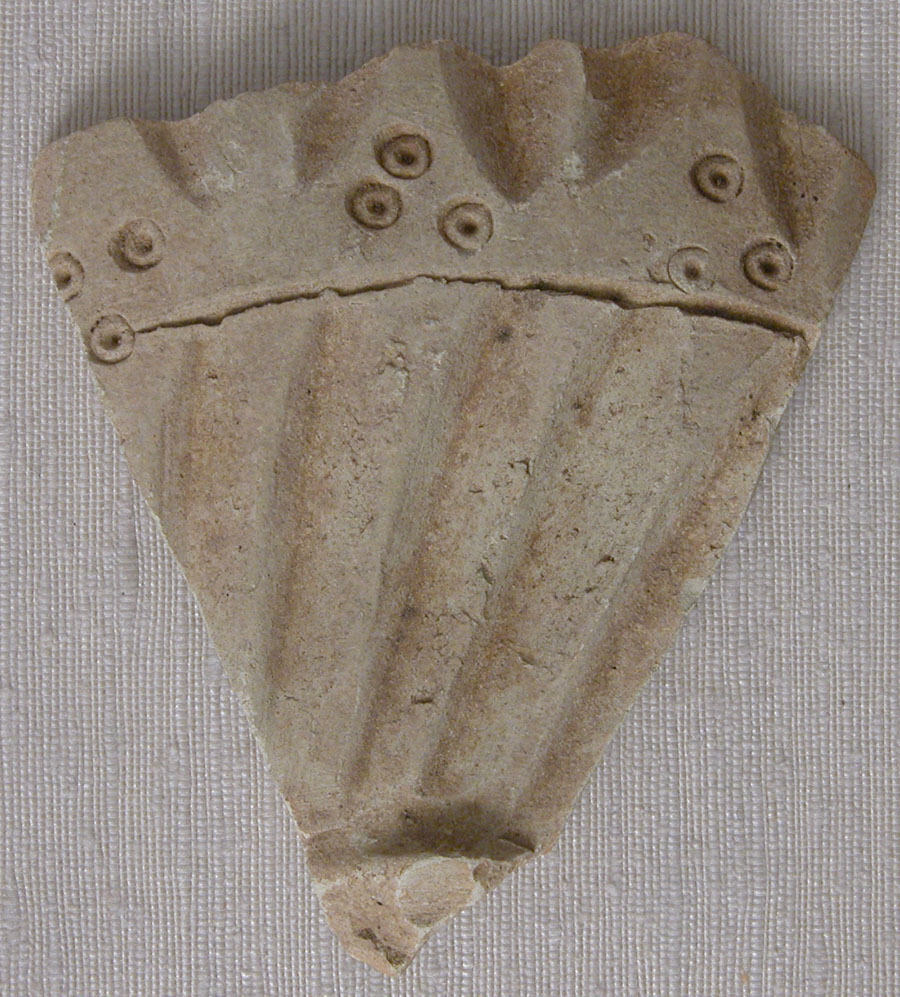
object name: fragment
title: Ceramic Fragment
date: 701-900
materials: earthenware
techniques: incising, stamping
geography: iraq